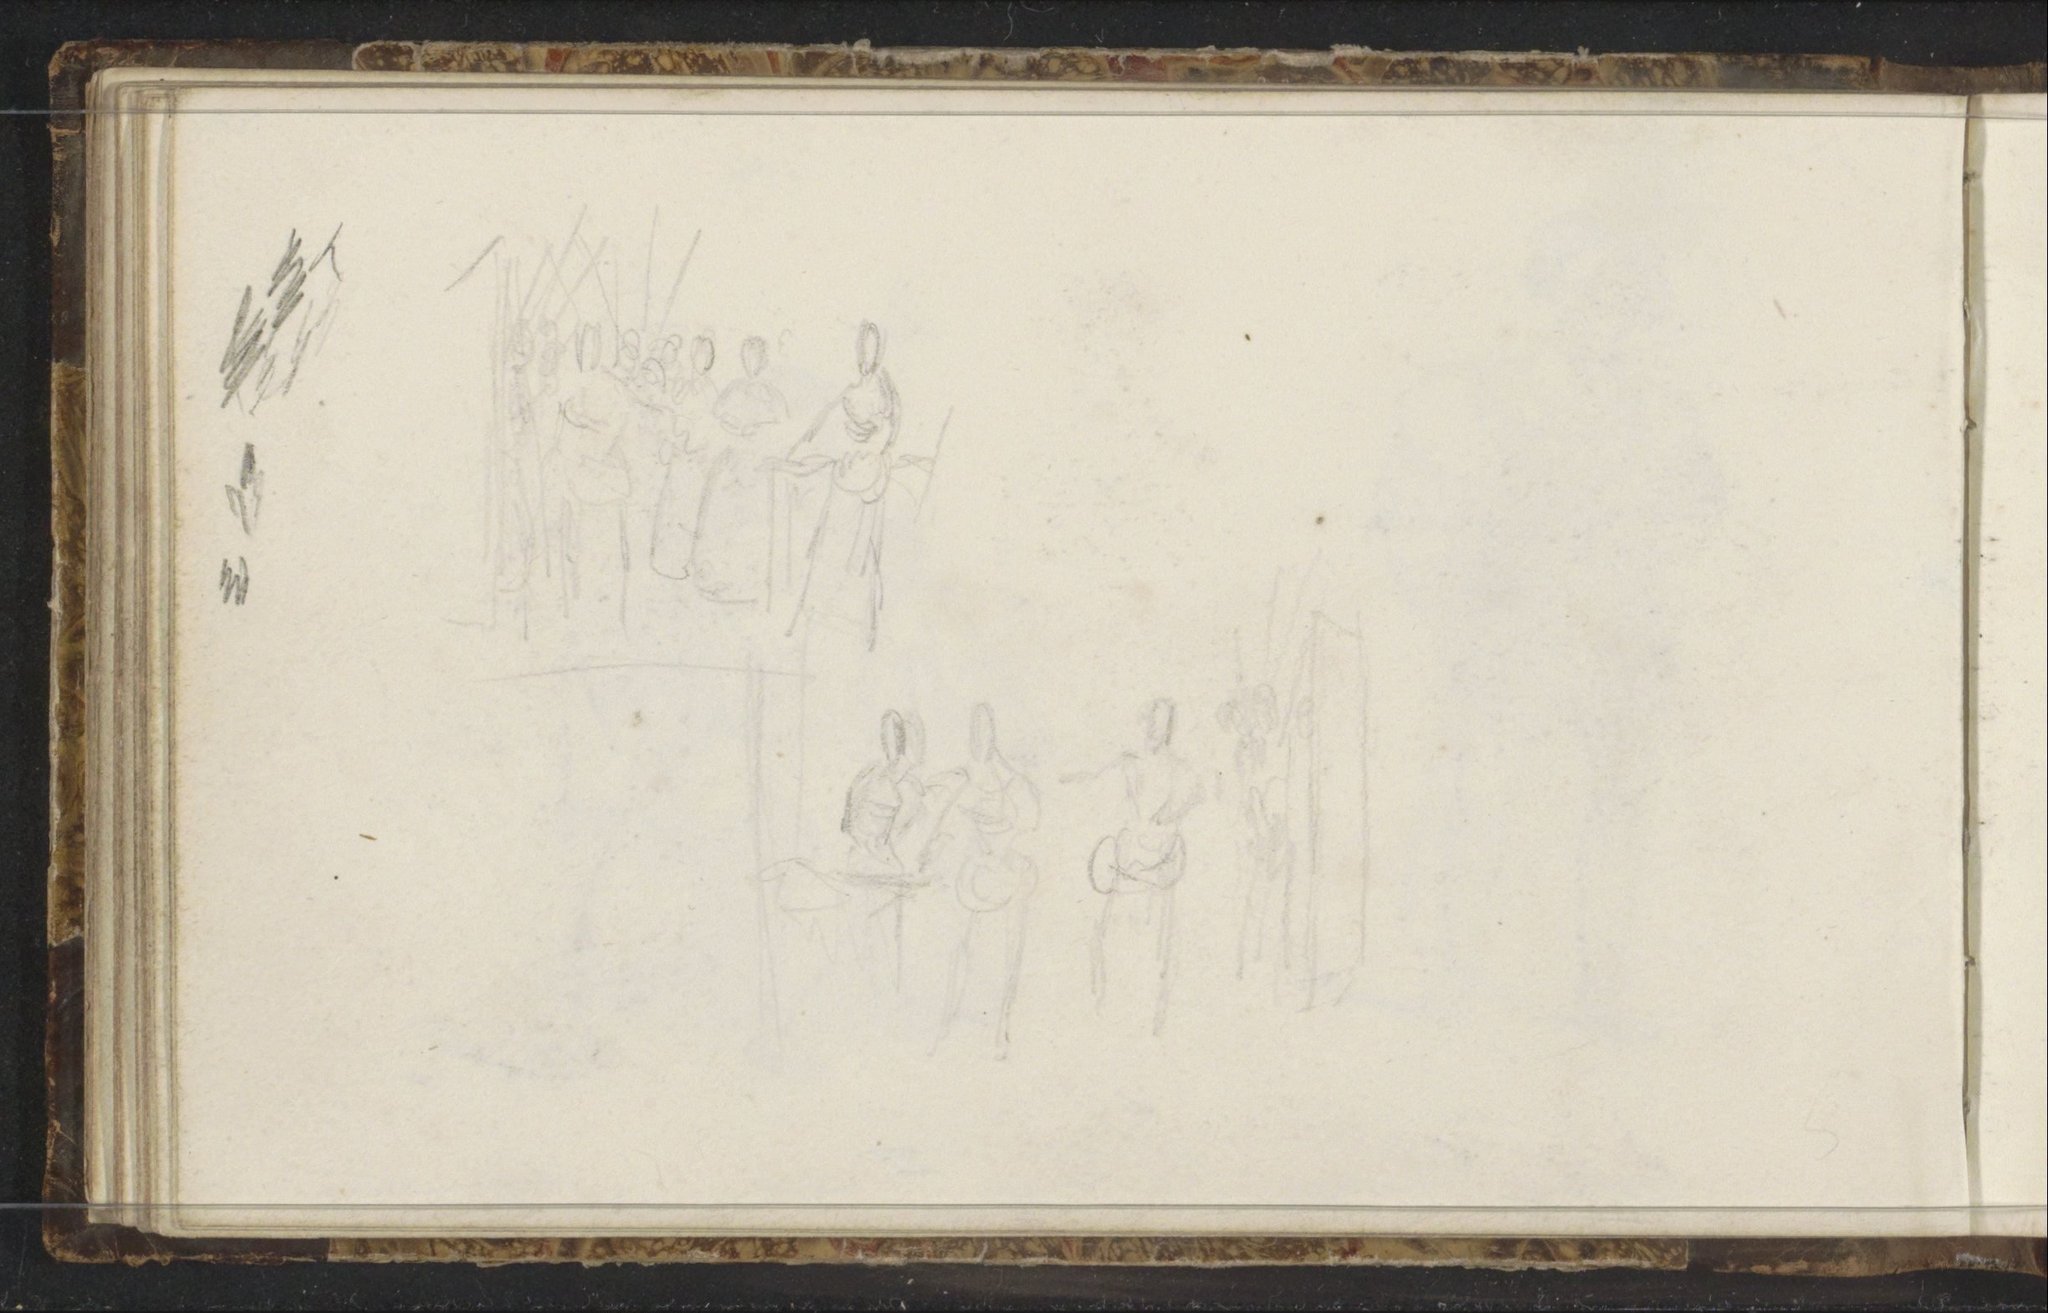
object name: sketchbook leaf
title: Groep figuren, mogelijk ridders of soldaten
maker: willem hendrik schmidt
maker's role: draughtsman, painter, print maker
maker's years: 1809-1849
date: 1819-1849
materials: paper, pencil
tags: anatomy (non-medical)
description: Blad 24 verso uit een schetsboek met 60 bladen.